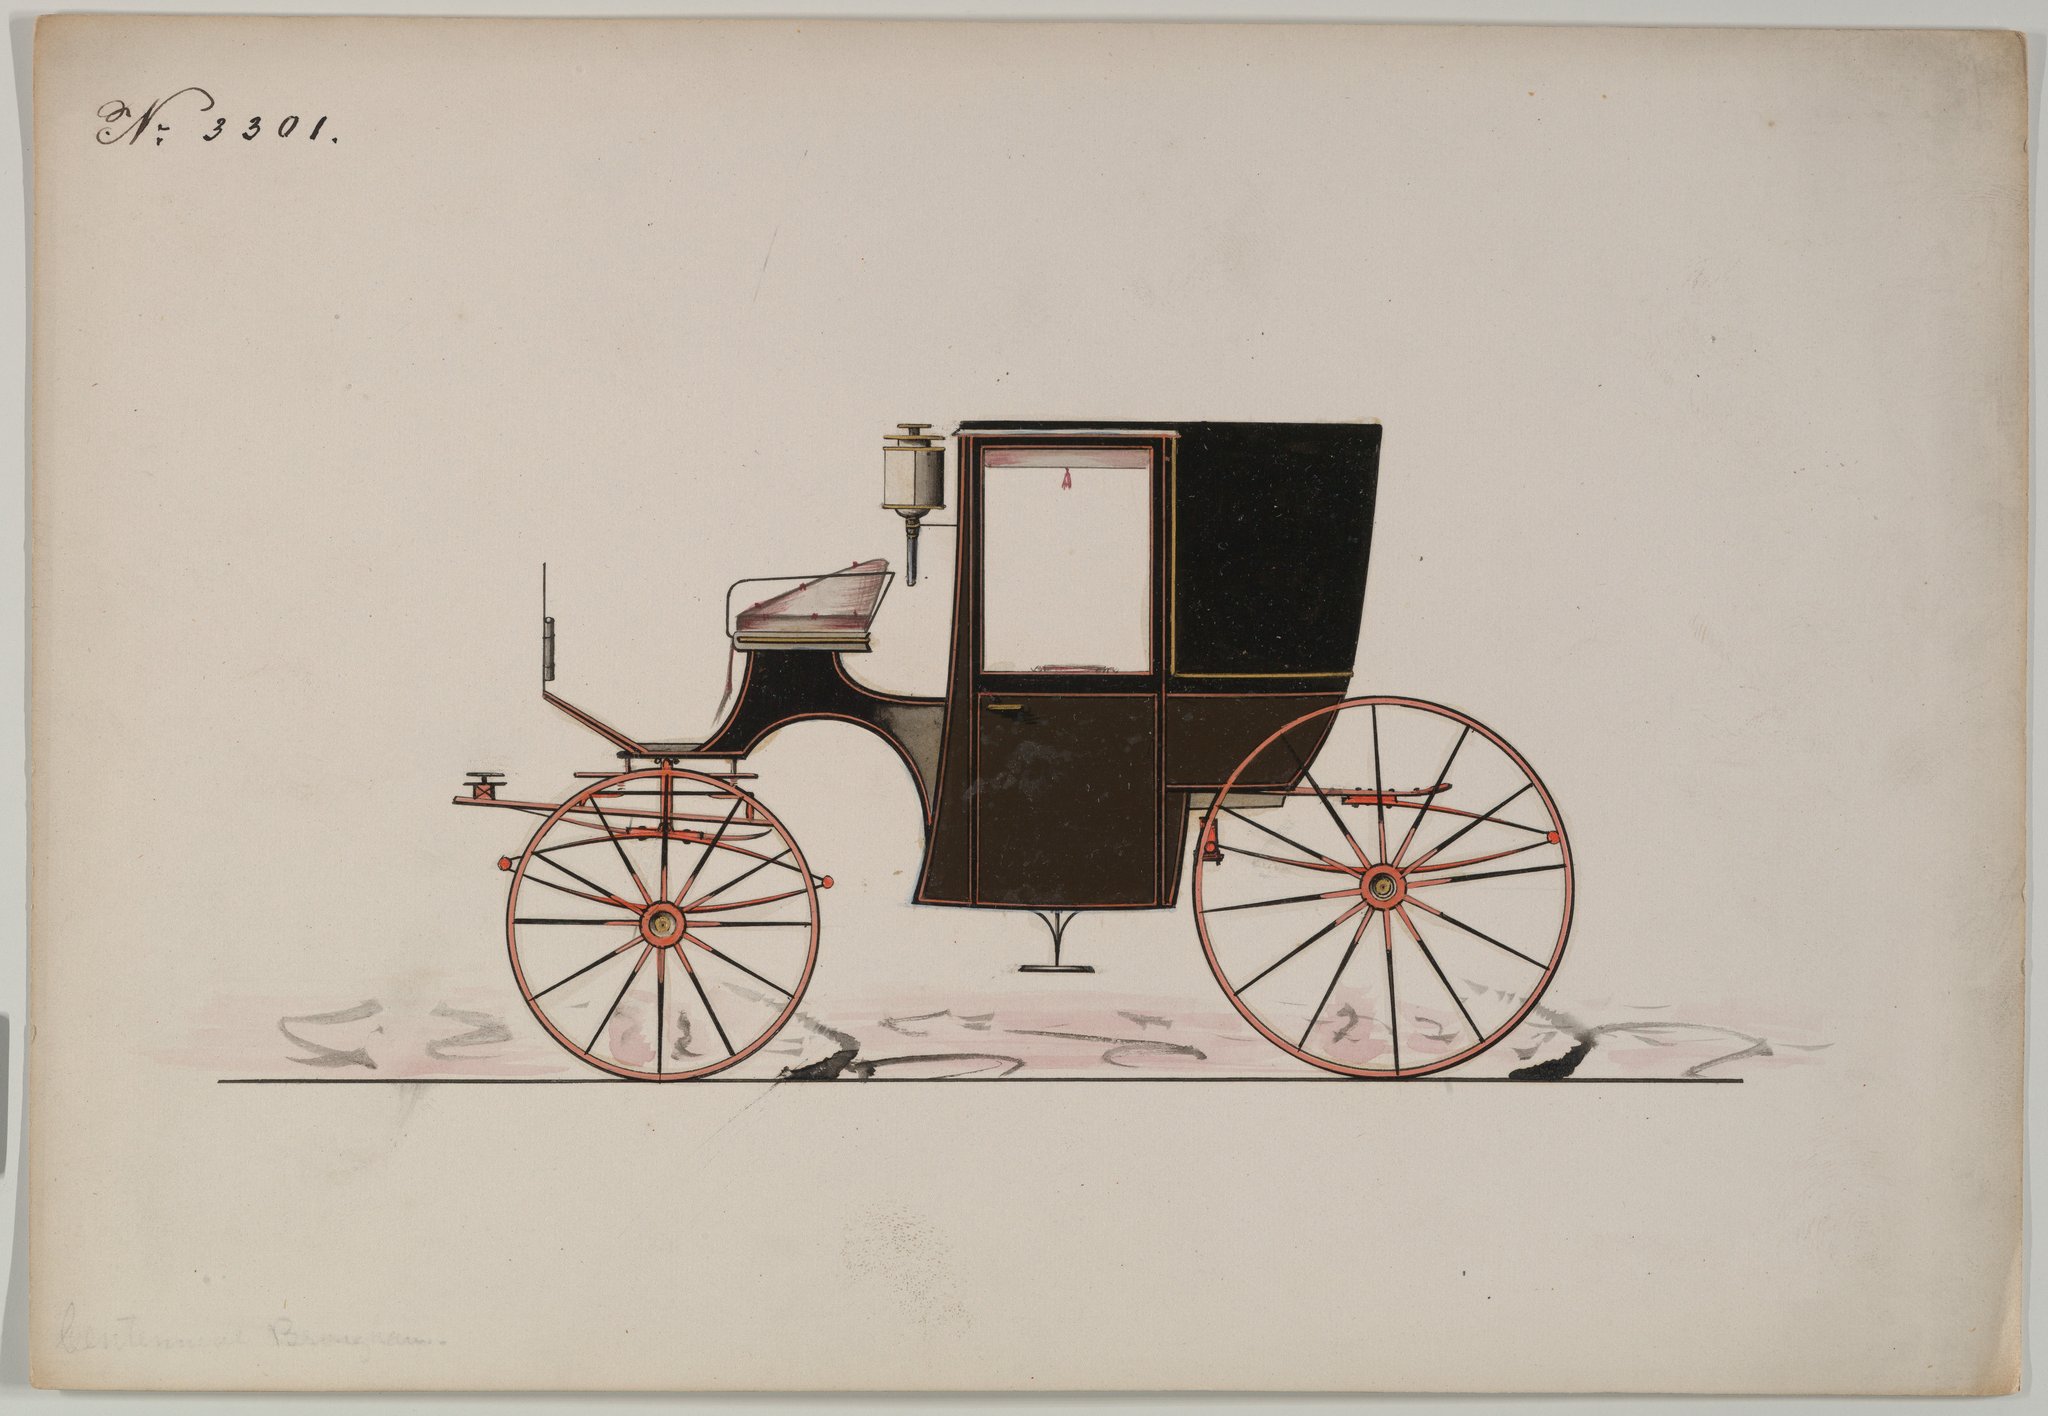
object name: drawing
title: Brougham #3301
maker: brewster & co.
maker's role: manufacturer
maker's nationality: american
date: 1877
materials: gouache, gum arabic, ink, watercolor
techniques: pen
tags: carriages